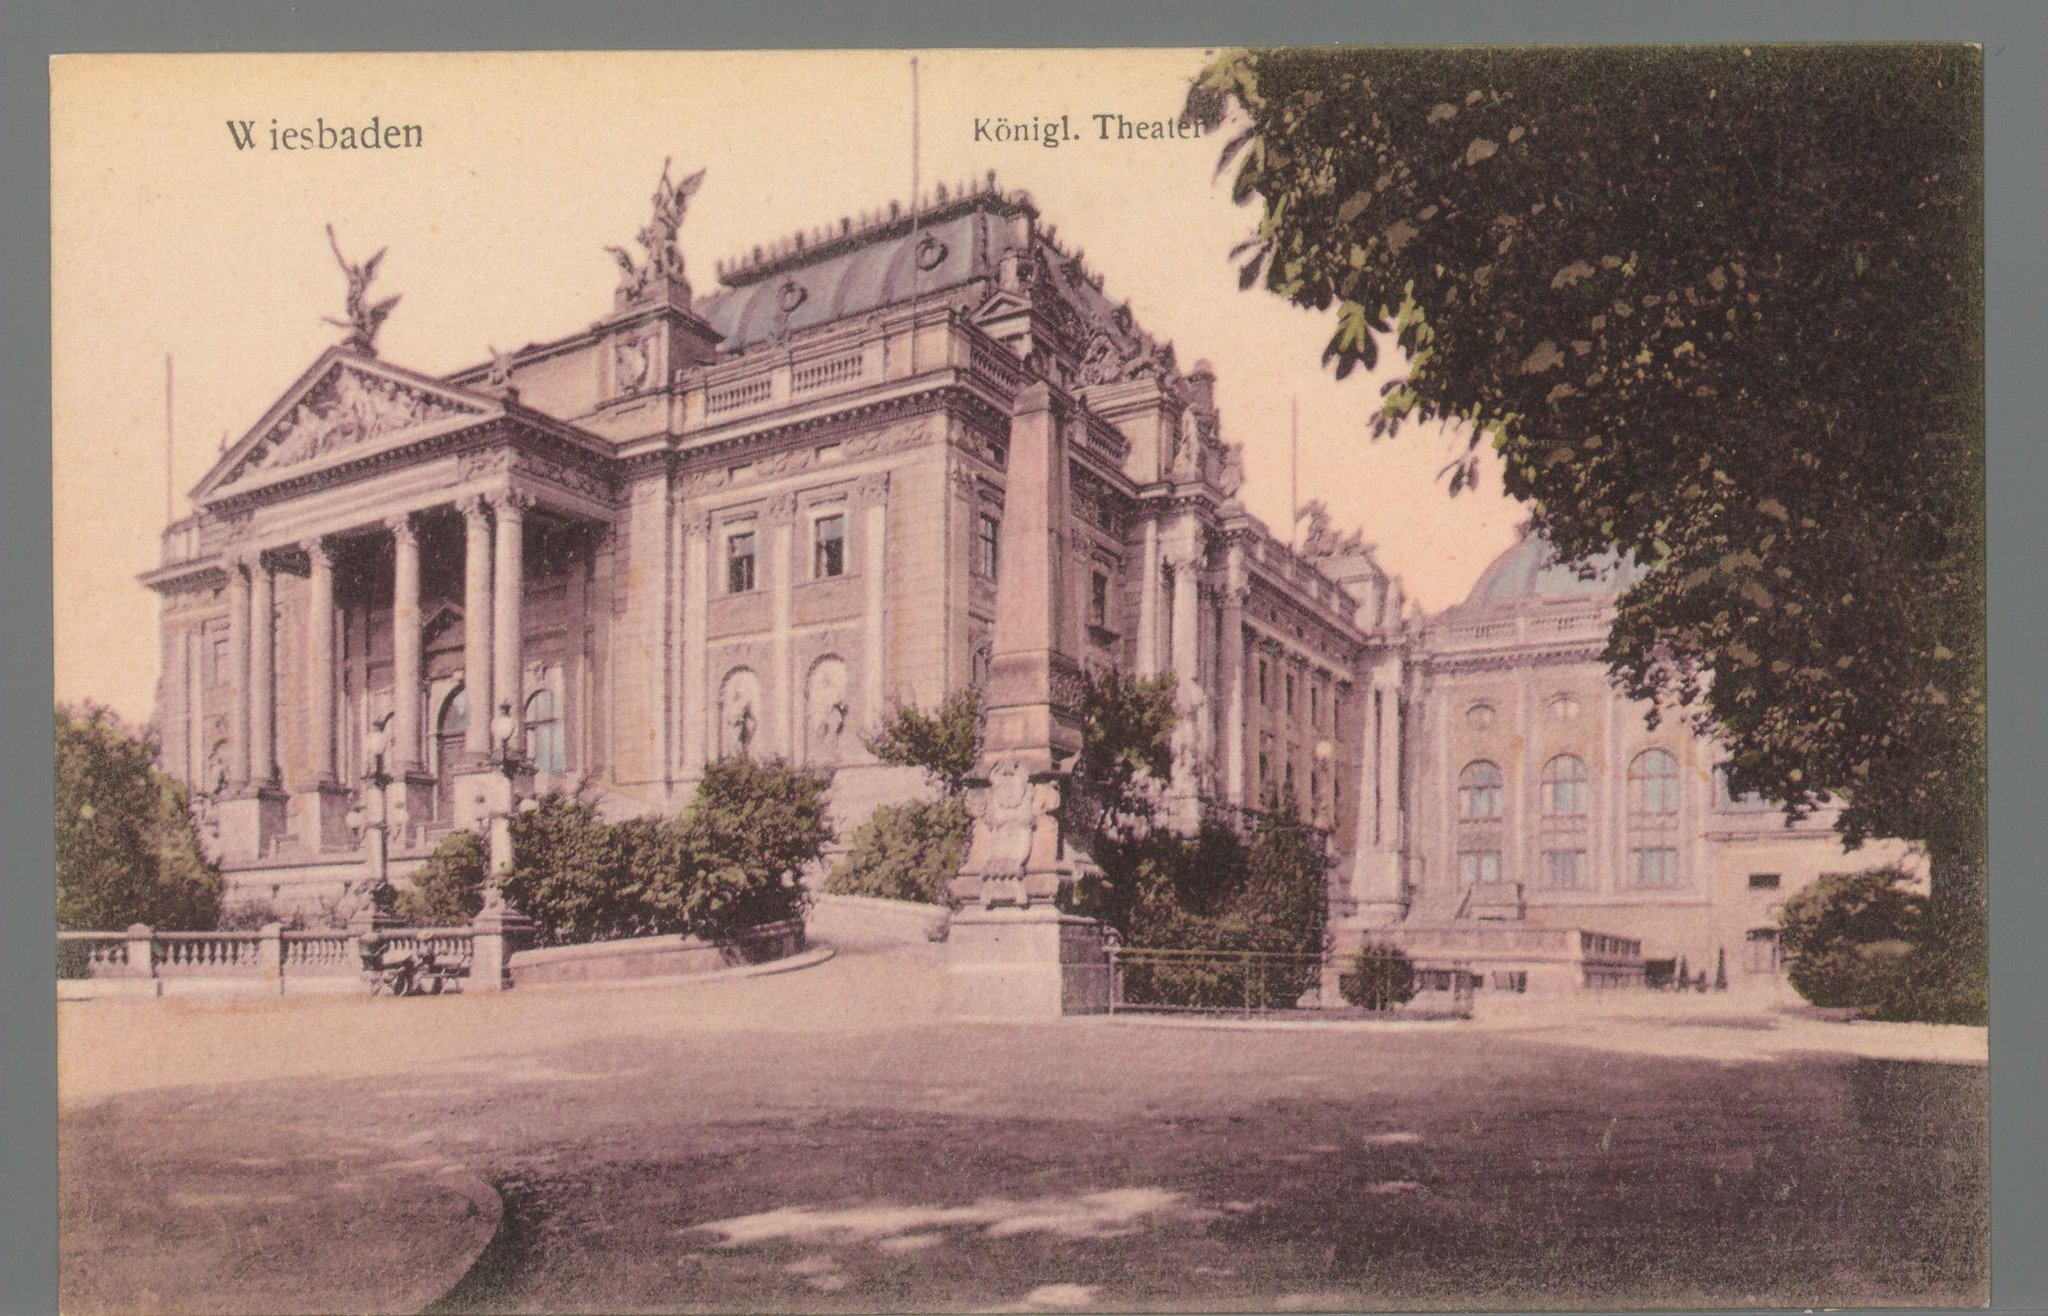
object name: photomechanical print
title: Wiesbaden. Königl. Theater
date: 1908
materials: cardboard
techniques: photograph, lithograph, writing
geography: wiesbaden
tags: theatre (building)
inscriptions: date